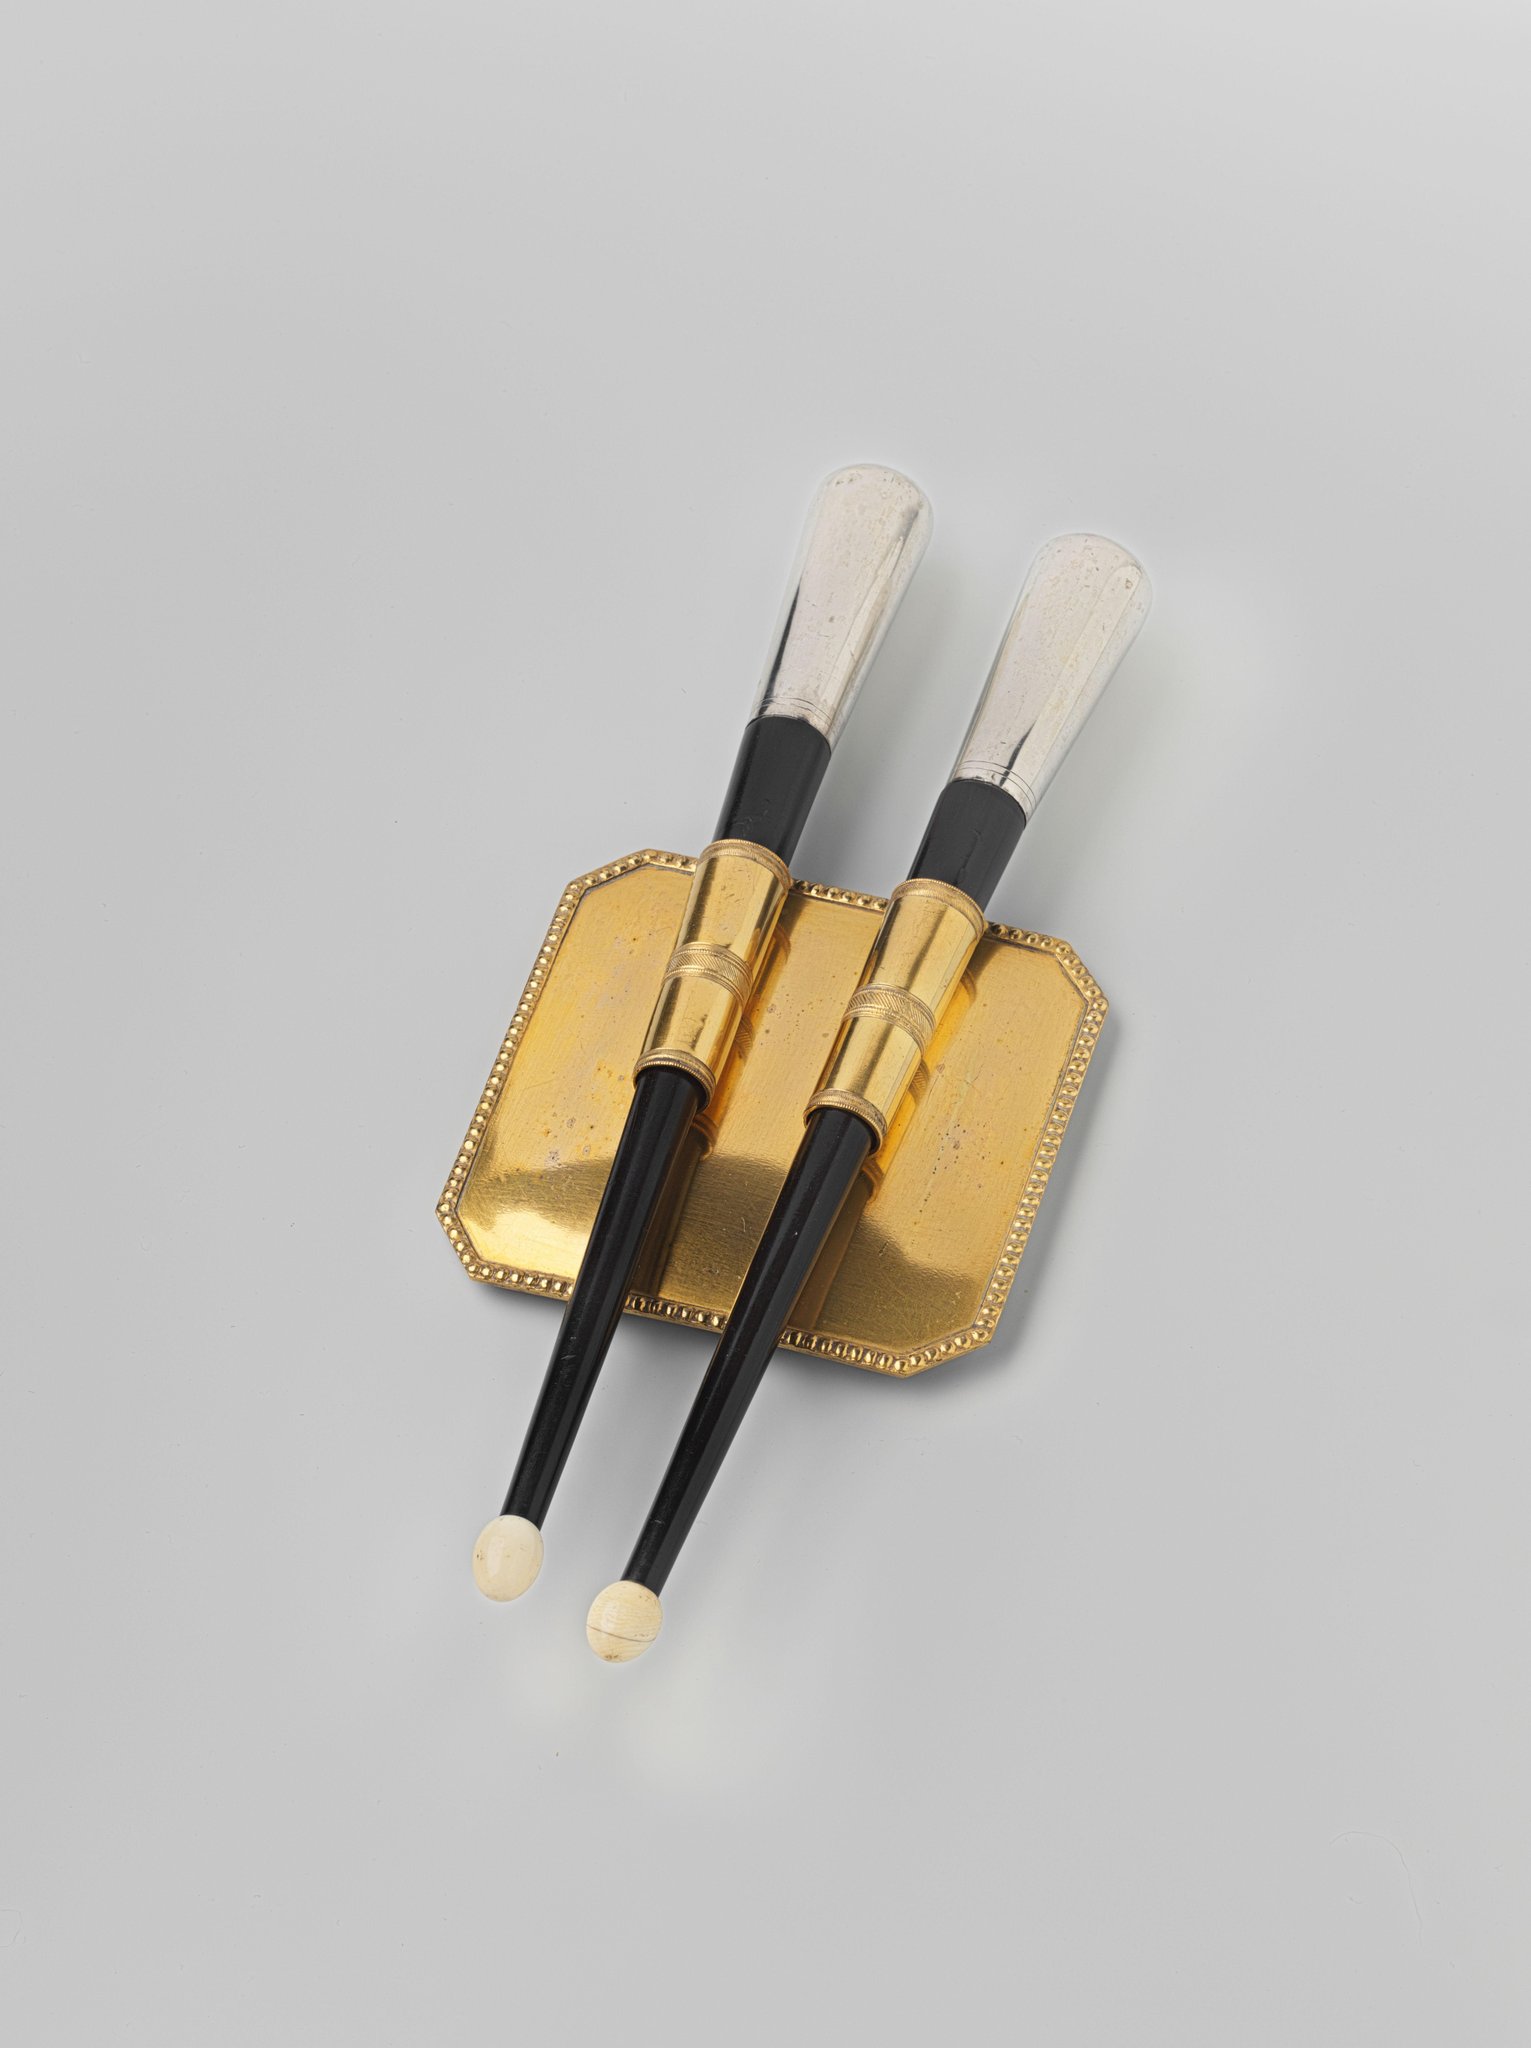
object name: beater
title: Drumsticks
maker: Anonymous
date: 1817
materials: wood, ivory, silver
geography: netherlands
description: Een ebbenhouten tromstok met ivoren knop.